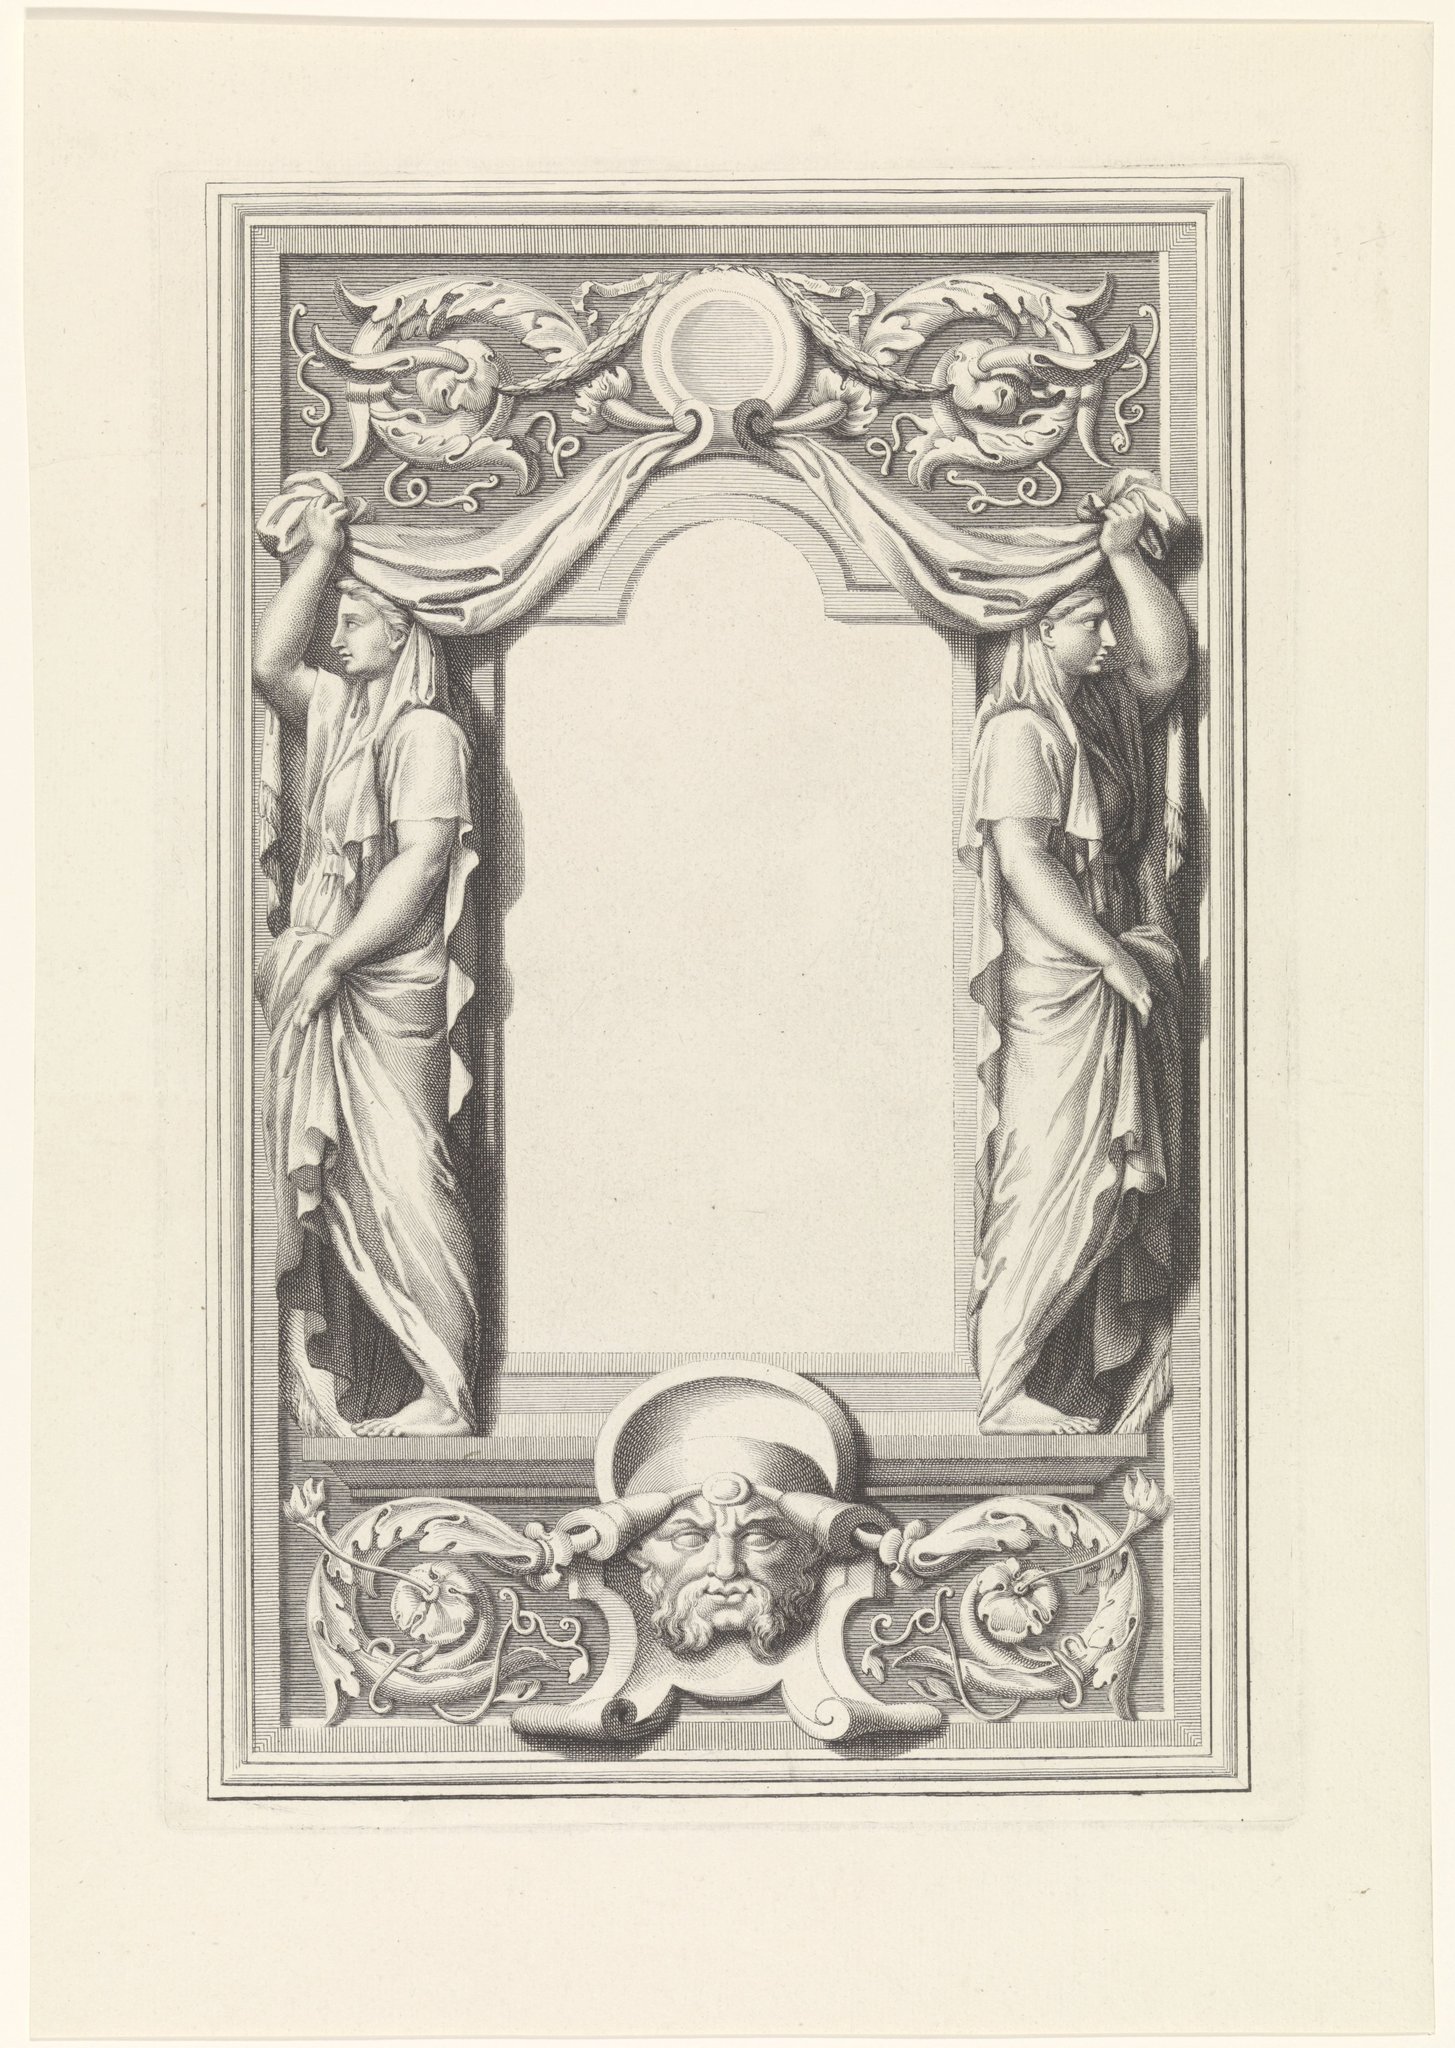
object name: print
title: Ornamentele omlijsting voor een titelpagina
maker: bernard picart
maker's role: draughtsman, print maker, publisher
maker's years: 1673-1733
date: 1683-1733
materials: paper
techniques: engraving, etching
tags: title-page, ornament ~ cartouche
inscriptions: collector's mark: Lugt 2228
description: Een leeg cartouche bestemd voor de titel, geflankeerd door twee vrouwen die een draperie omhoog houden.